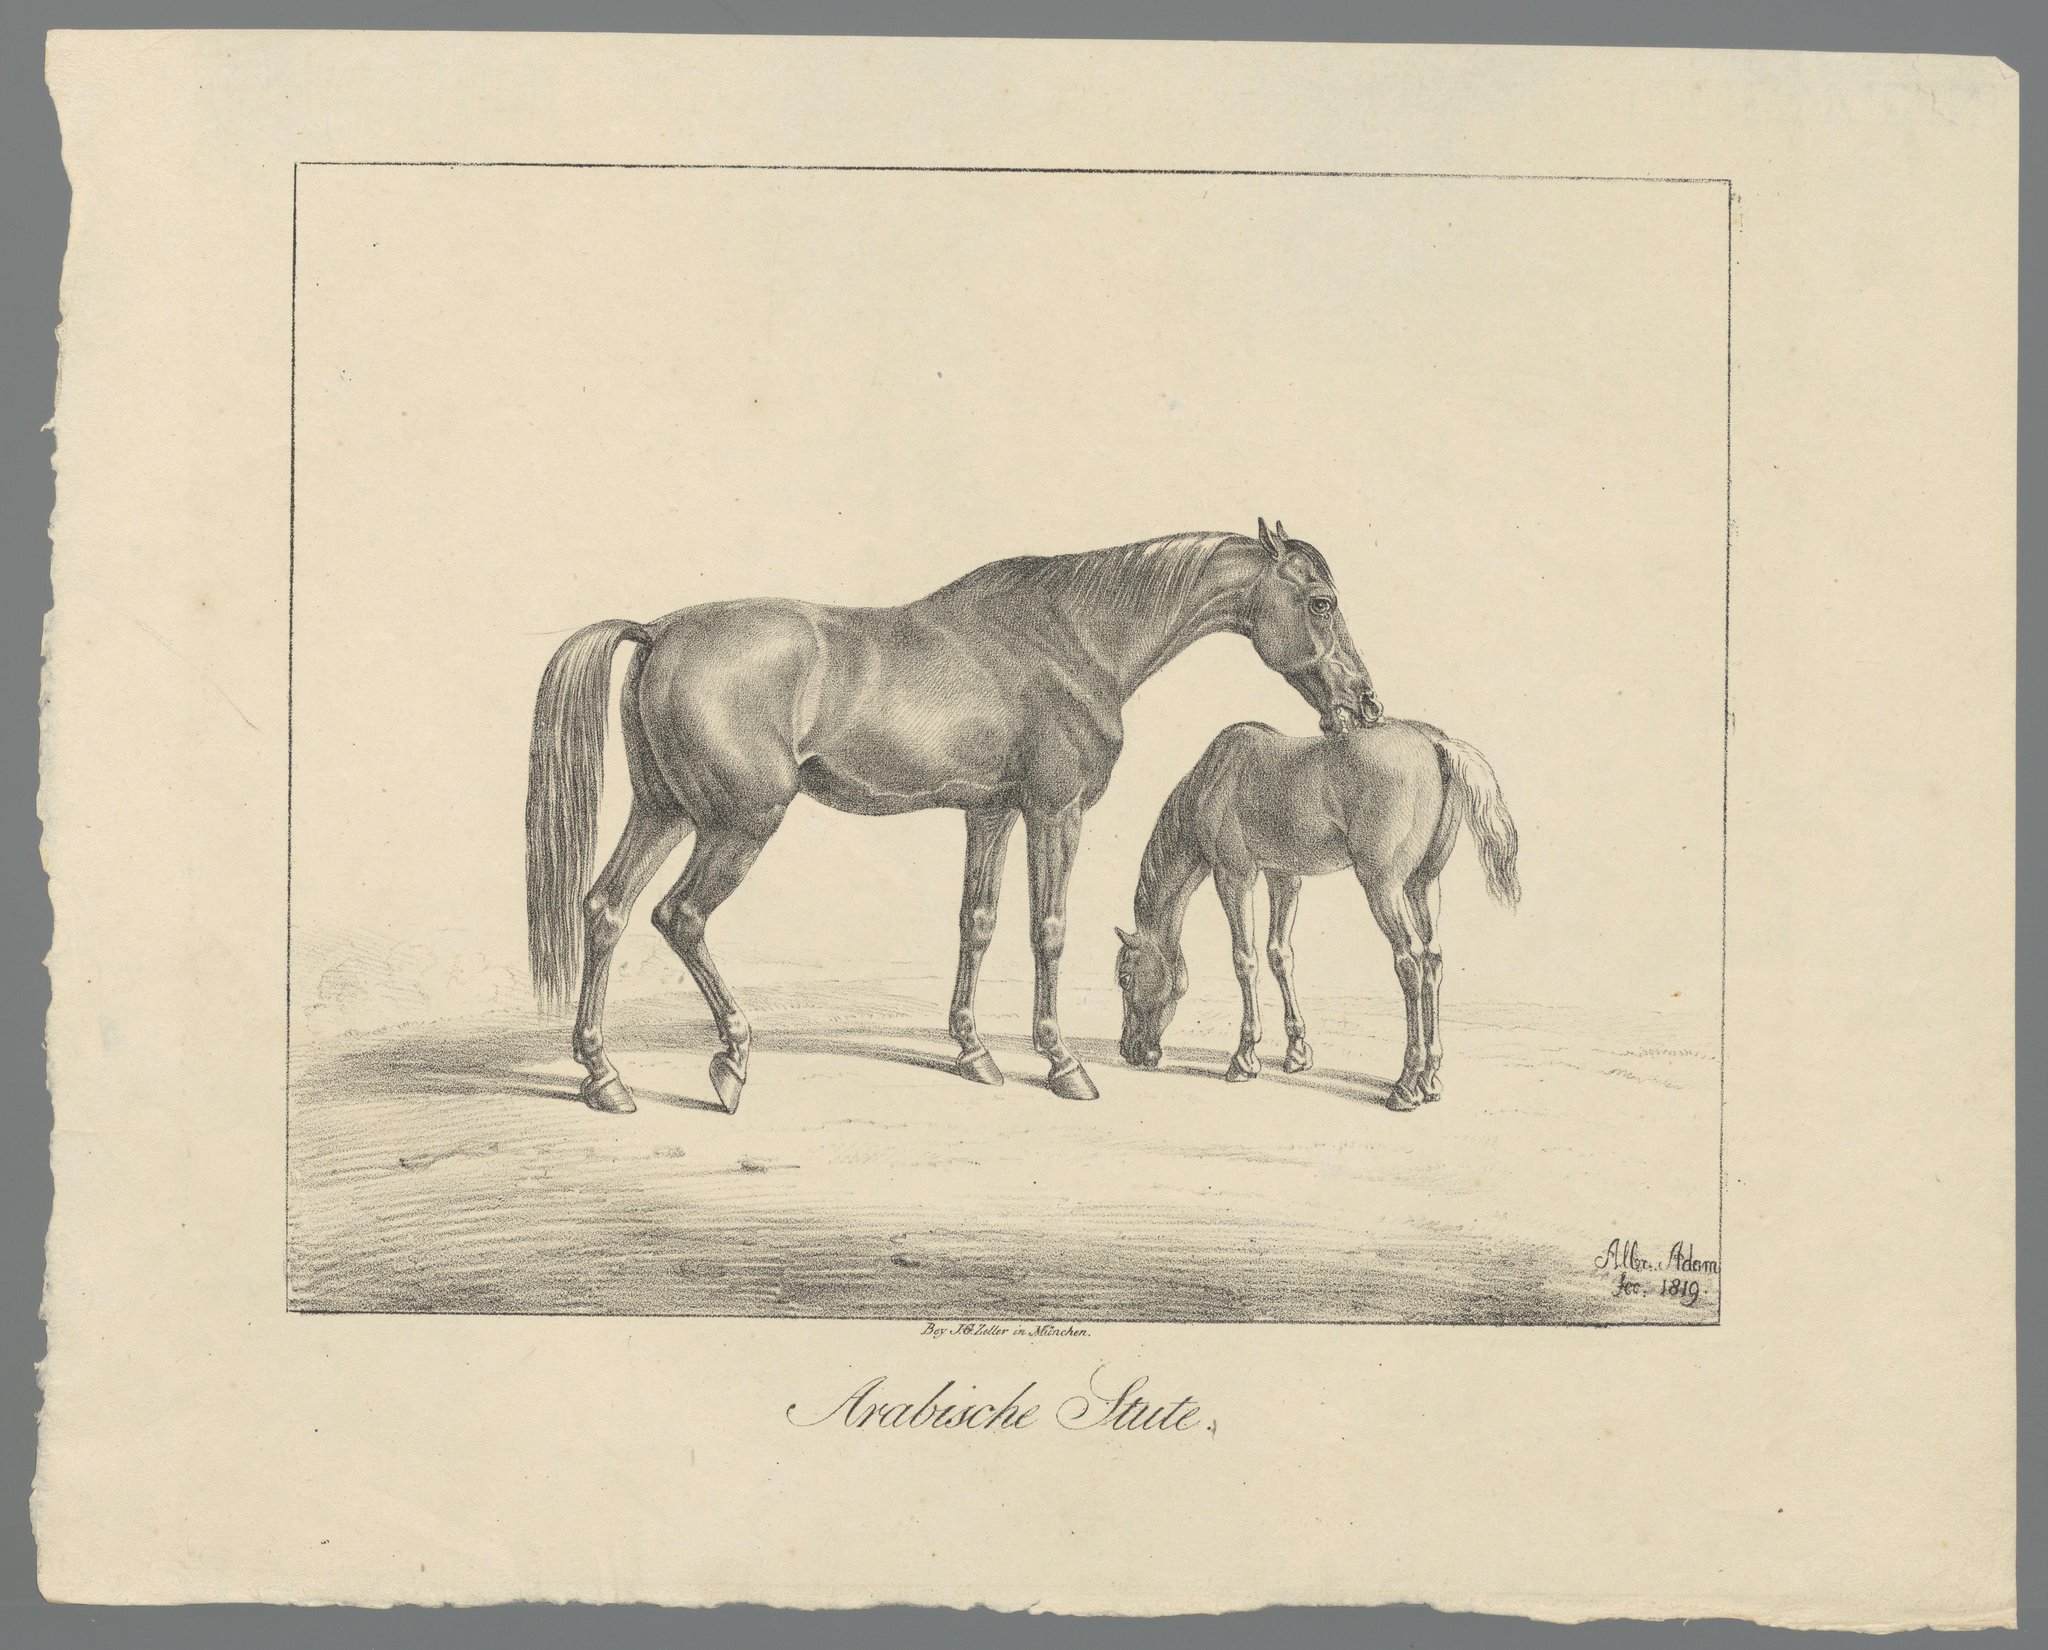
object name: print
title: Thier-Studien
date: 1819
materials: paper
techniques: lithograph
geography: munich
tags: horse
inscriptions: collector's mark: Lugt 2228